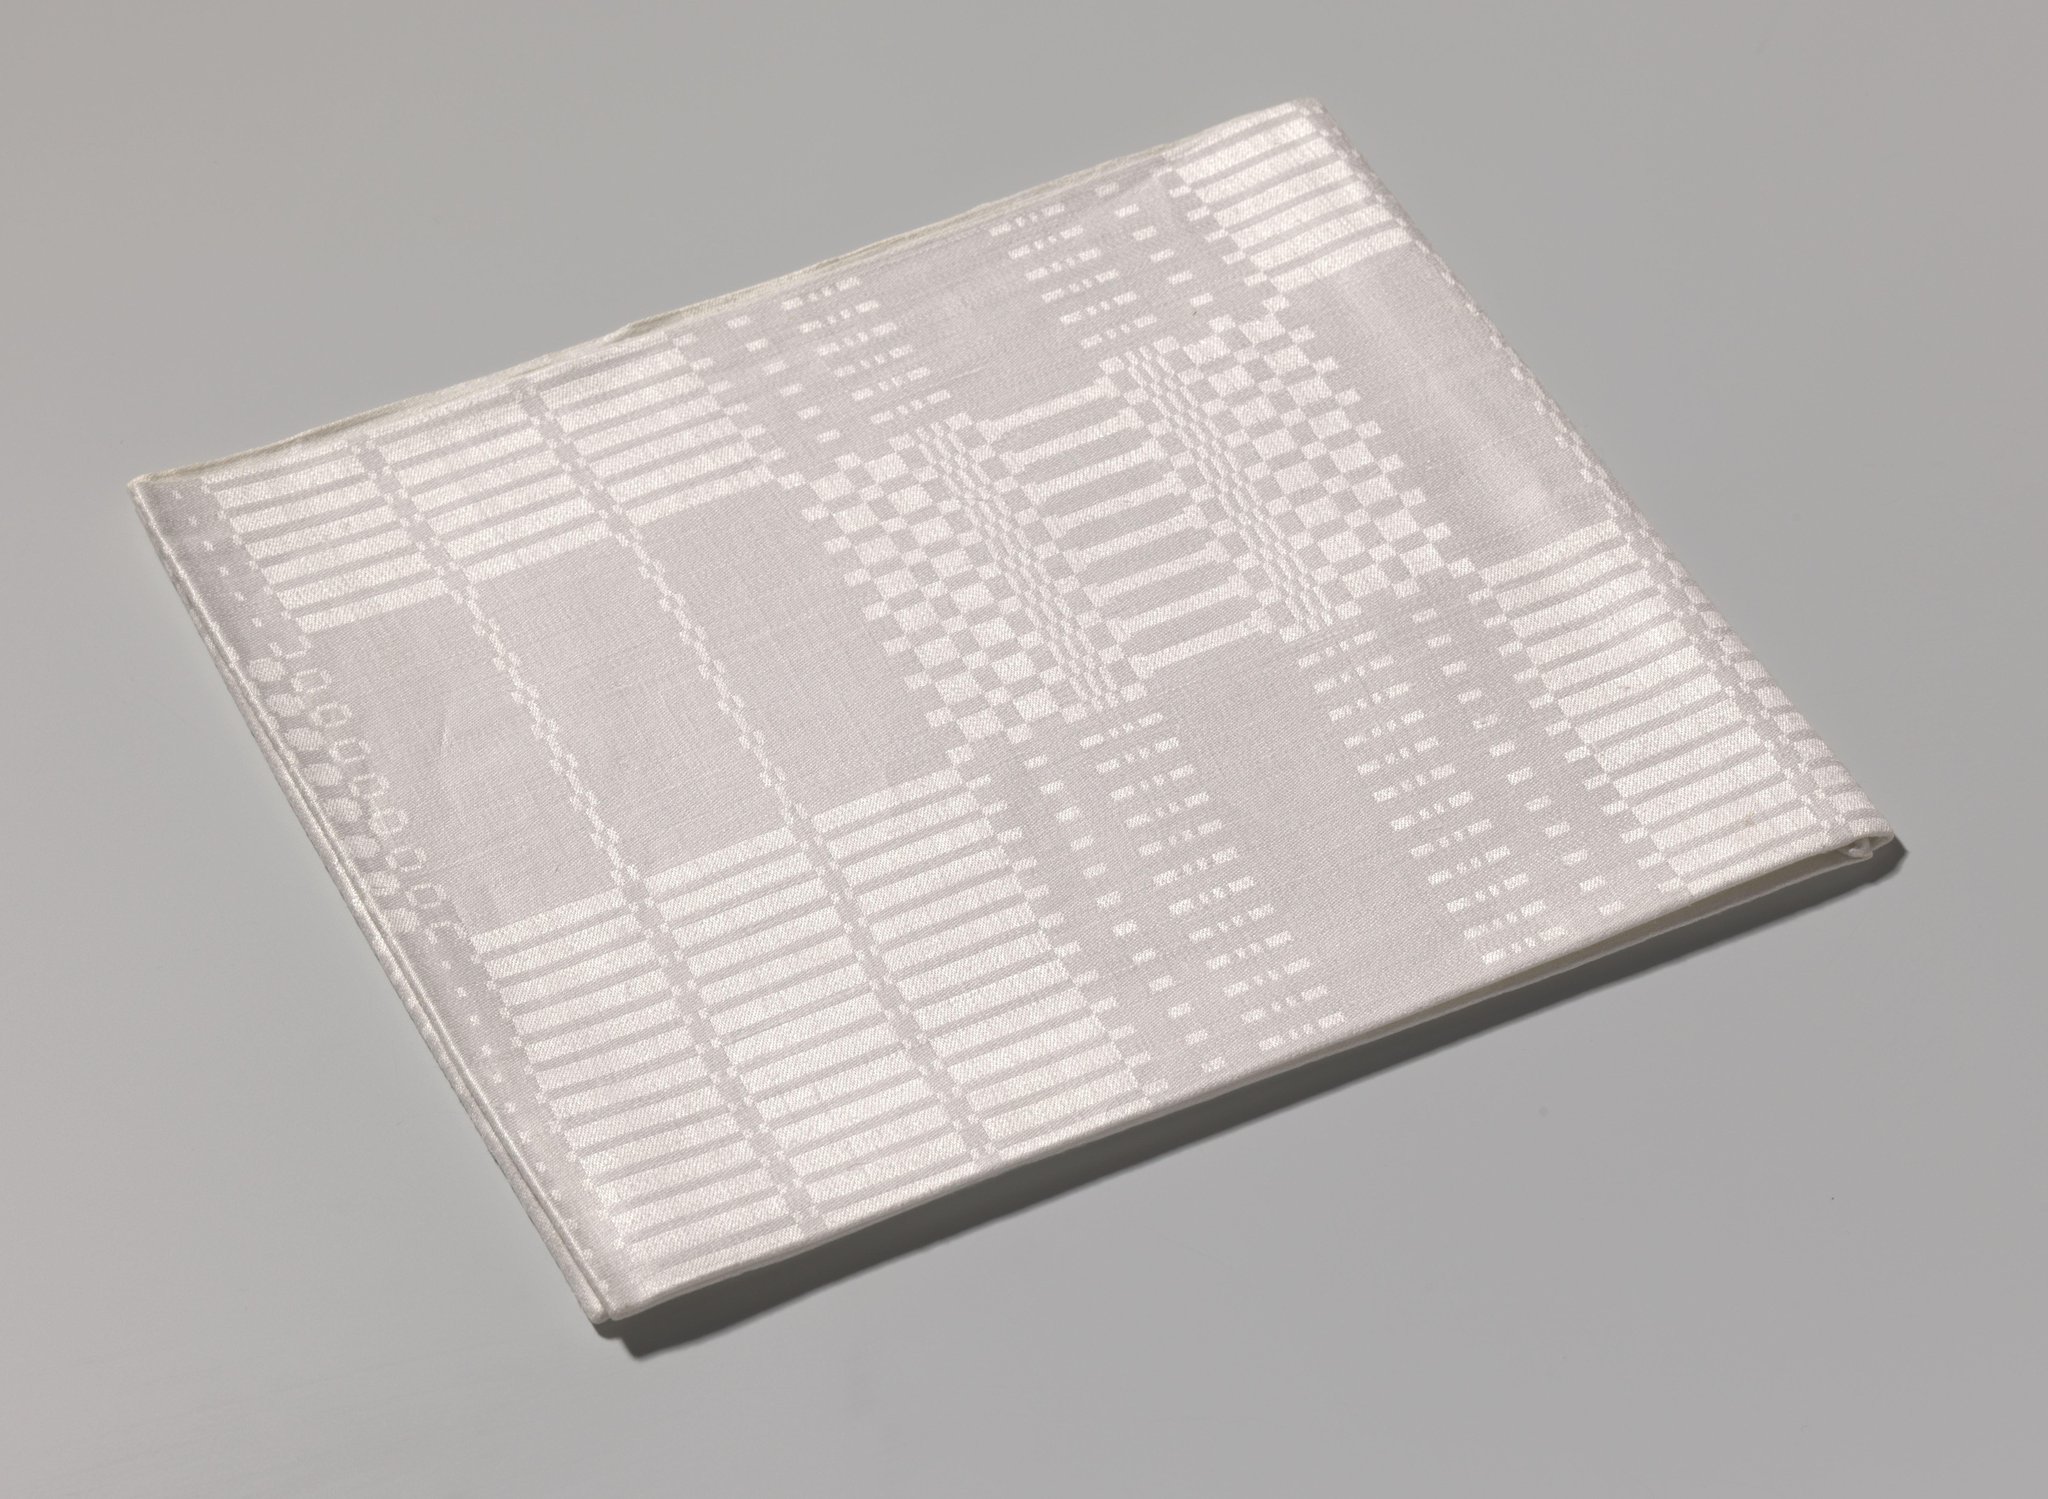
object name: napkin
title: Servet met pellenpatroon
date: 1790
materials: linen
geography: northern netherlands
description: Servet van wit linnen met pellenpatroon, merk kroon SW 35 en 1790.